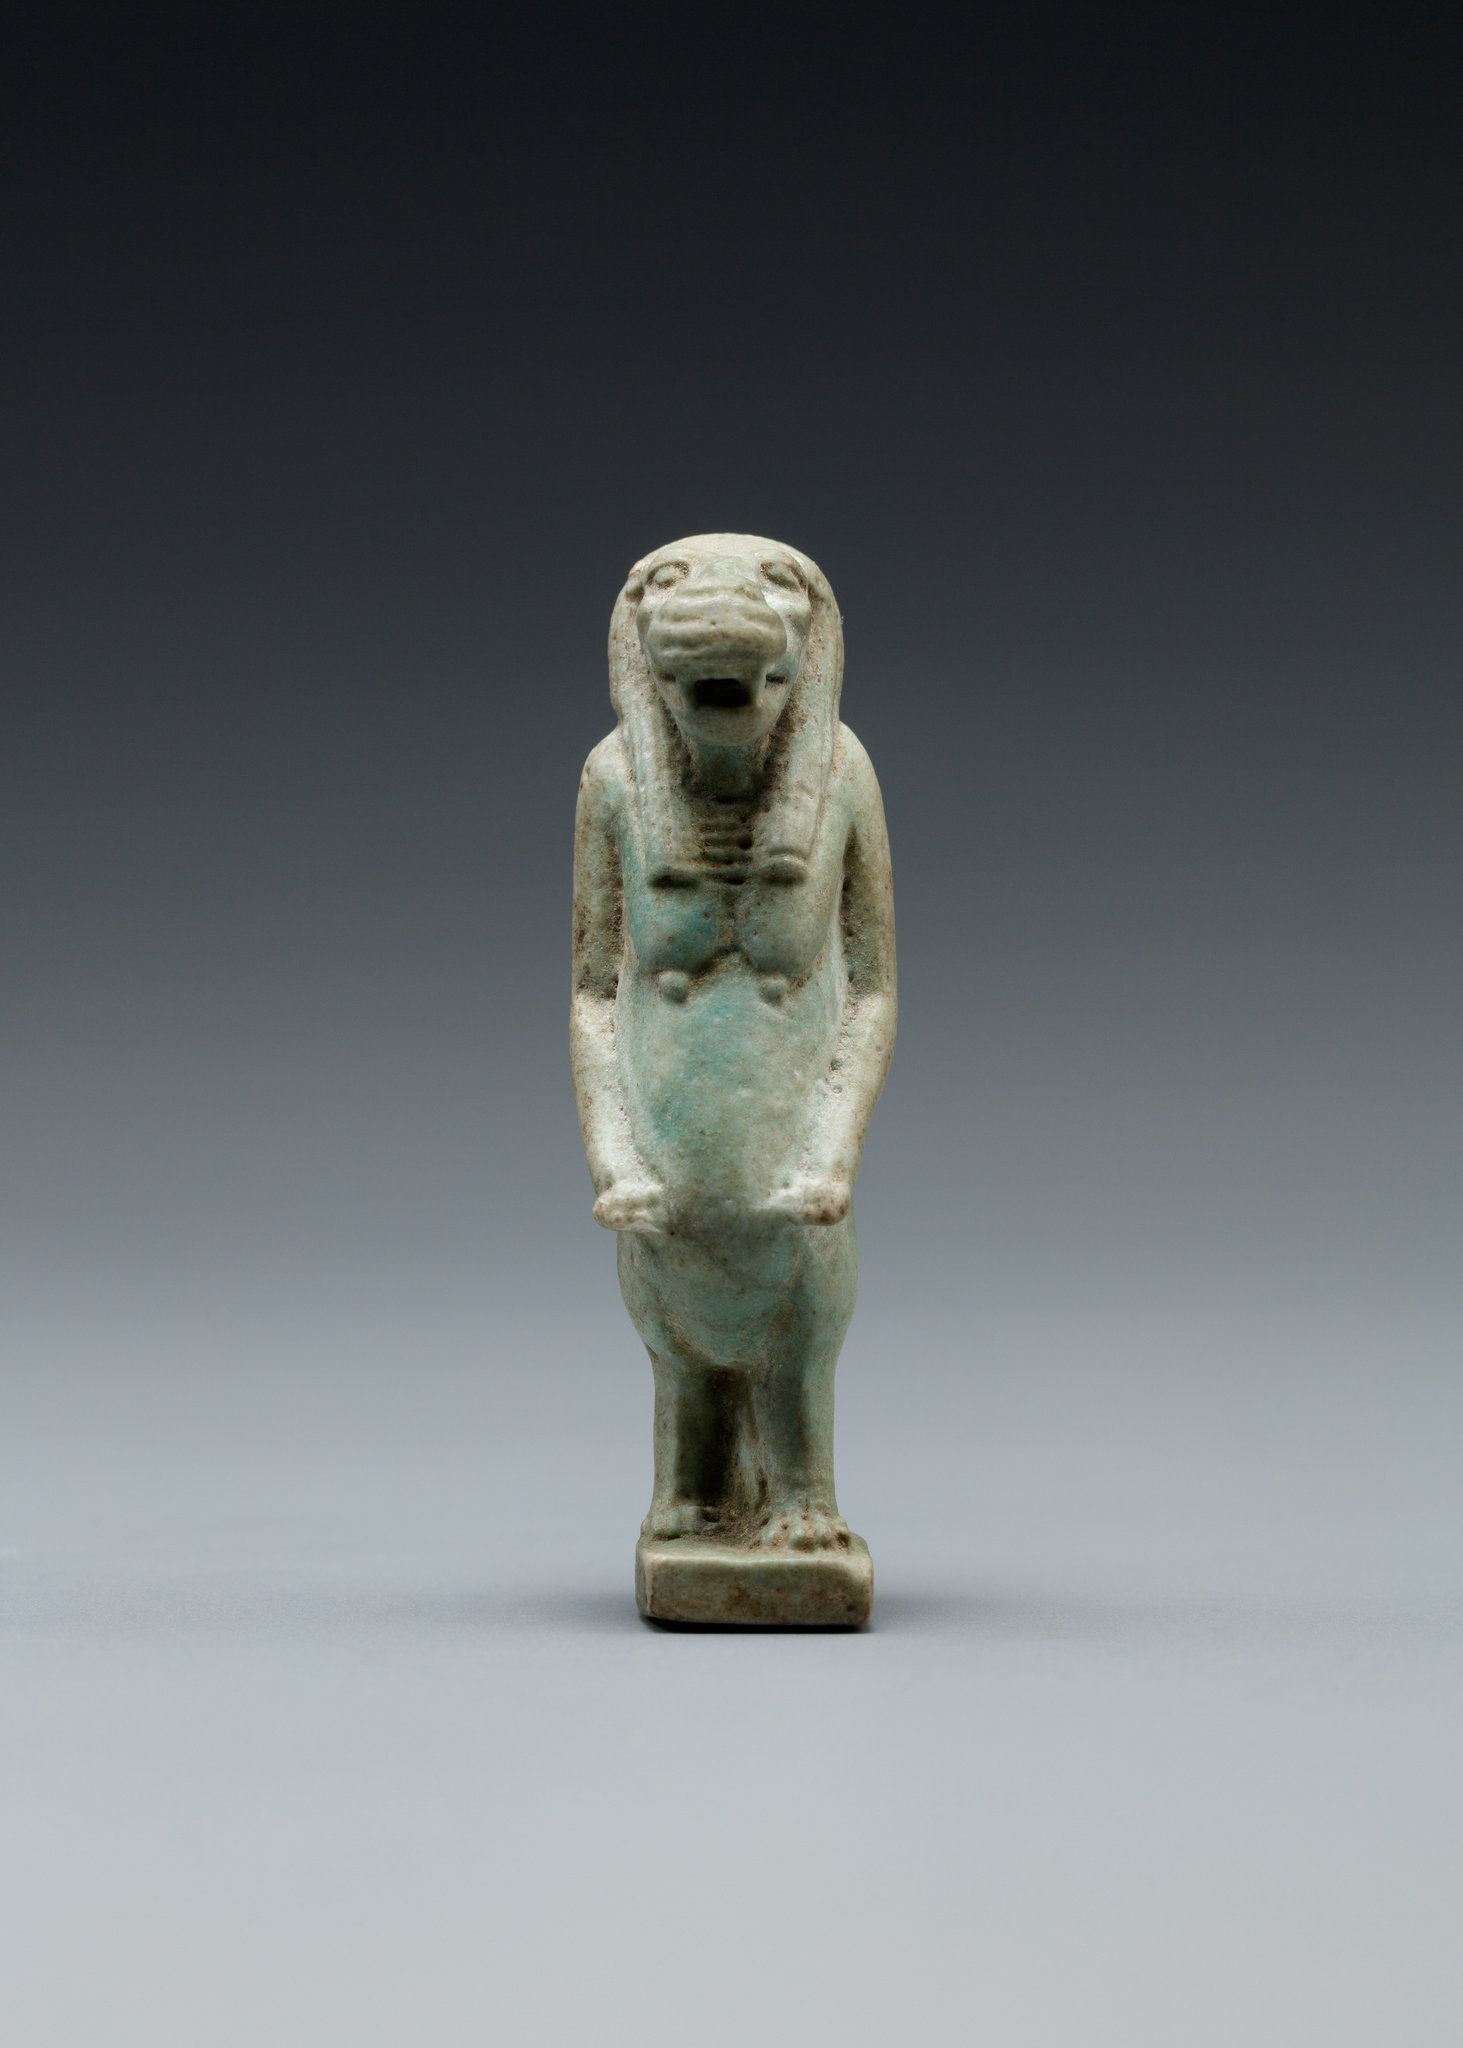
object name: amulet, taweret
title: Amulet: Figure of Taweret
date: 664-332 BCE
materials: faience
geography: egypt